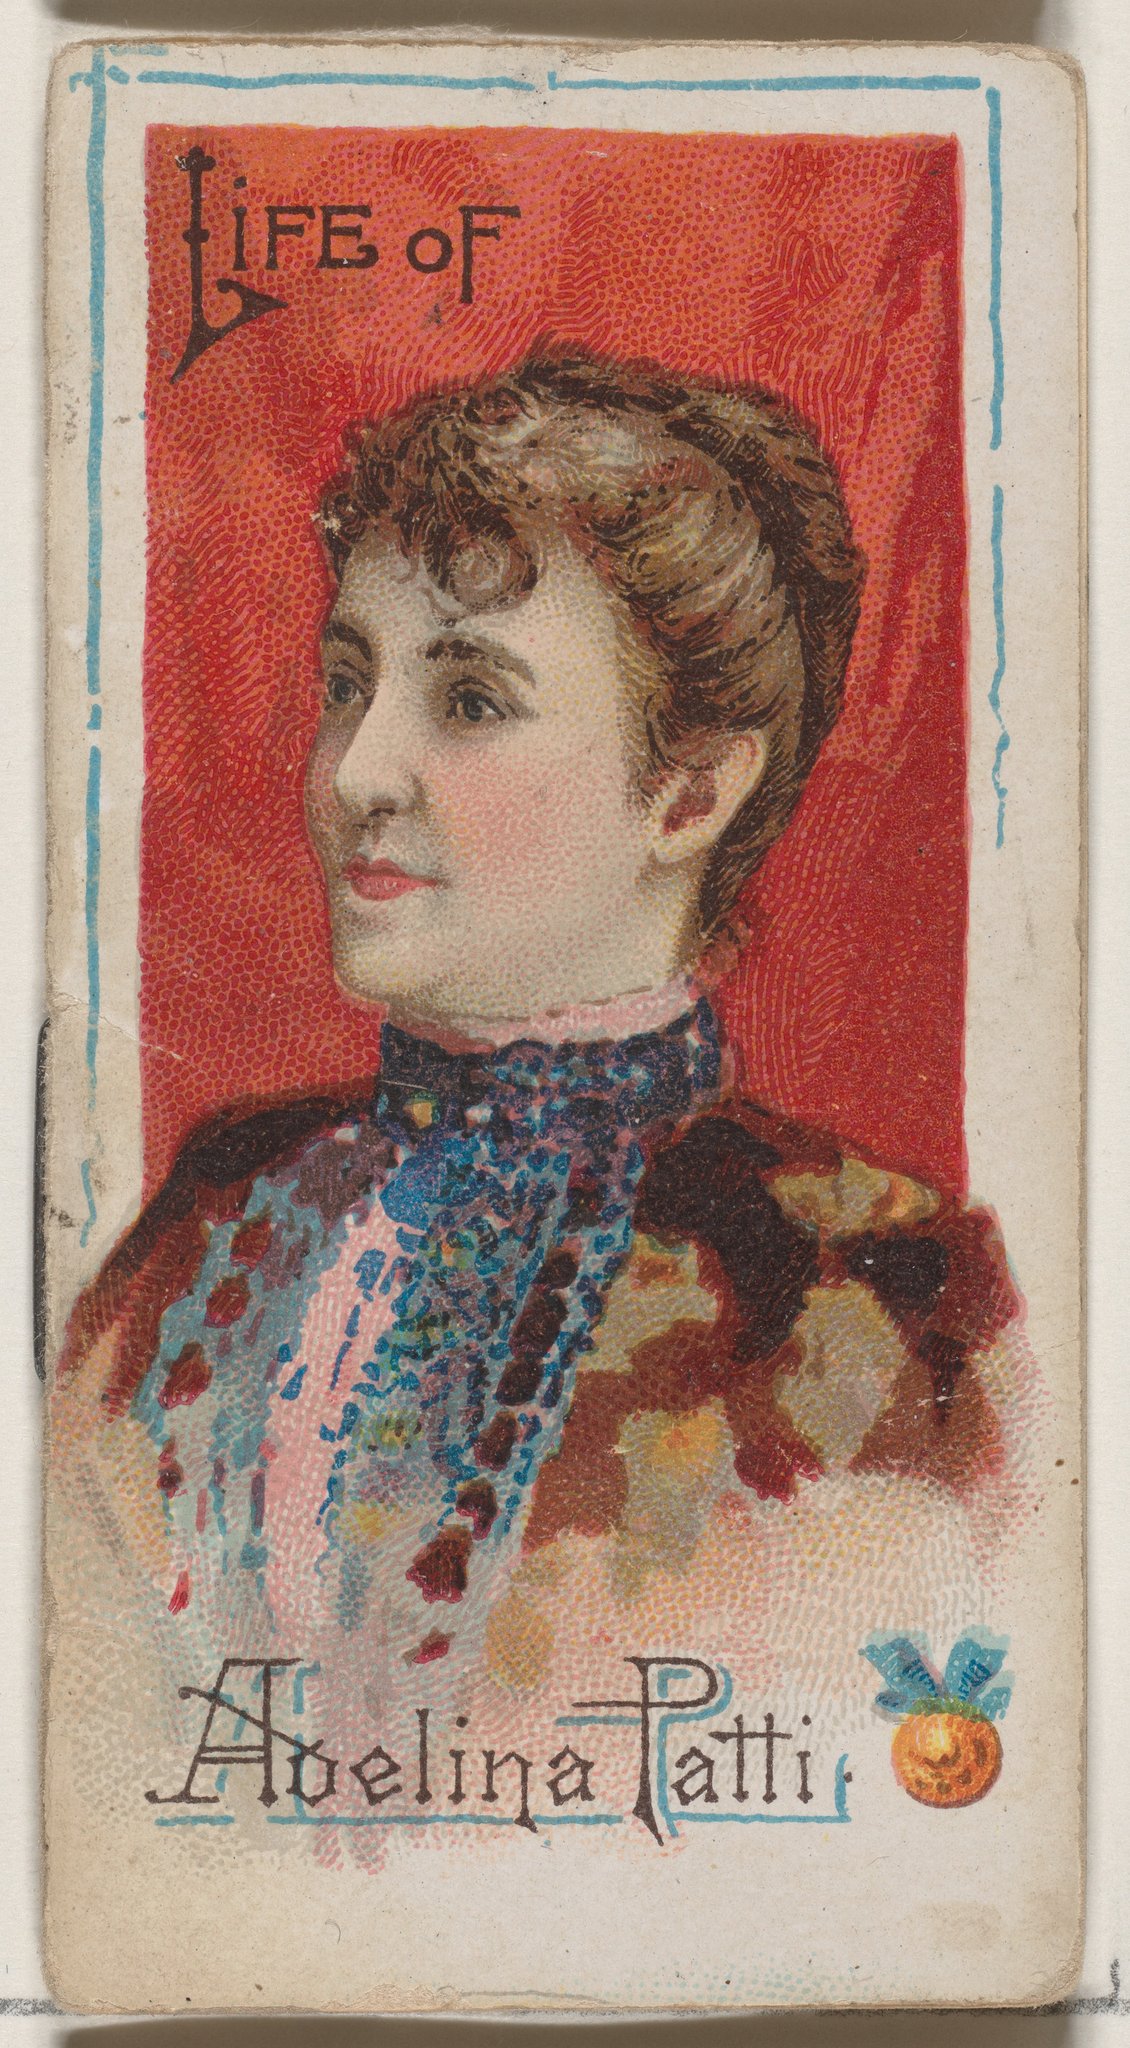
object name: print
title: Life of Adelina Patti-Nicolini, from the Histories of Poor Boys and Famous People series of booklets (N79) for Duke brand cigarettes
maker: w. duke, sons & co.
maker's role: publisher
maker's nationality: american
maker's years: 1870-1920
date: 1888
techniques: color lithograph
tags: women